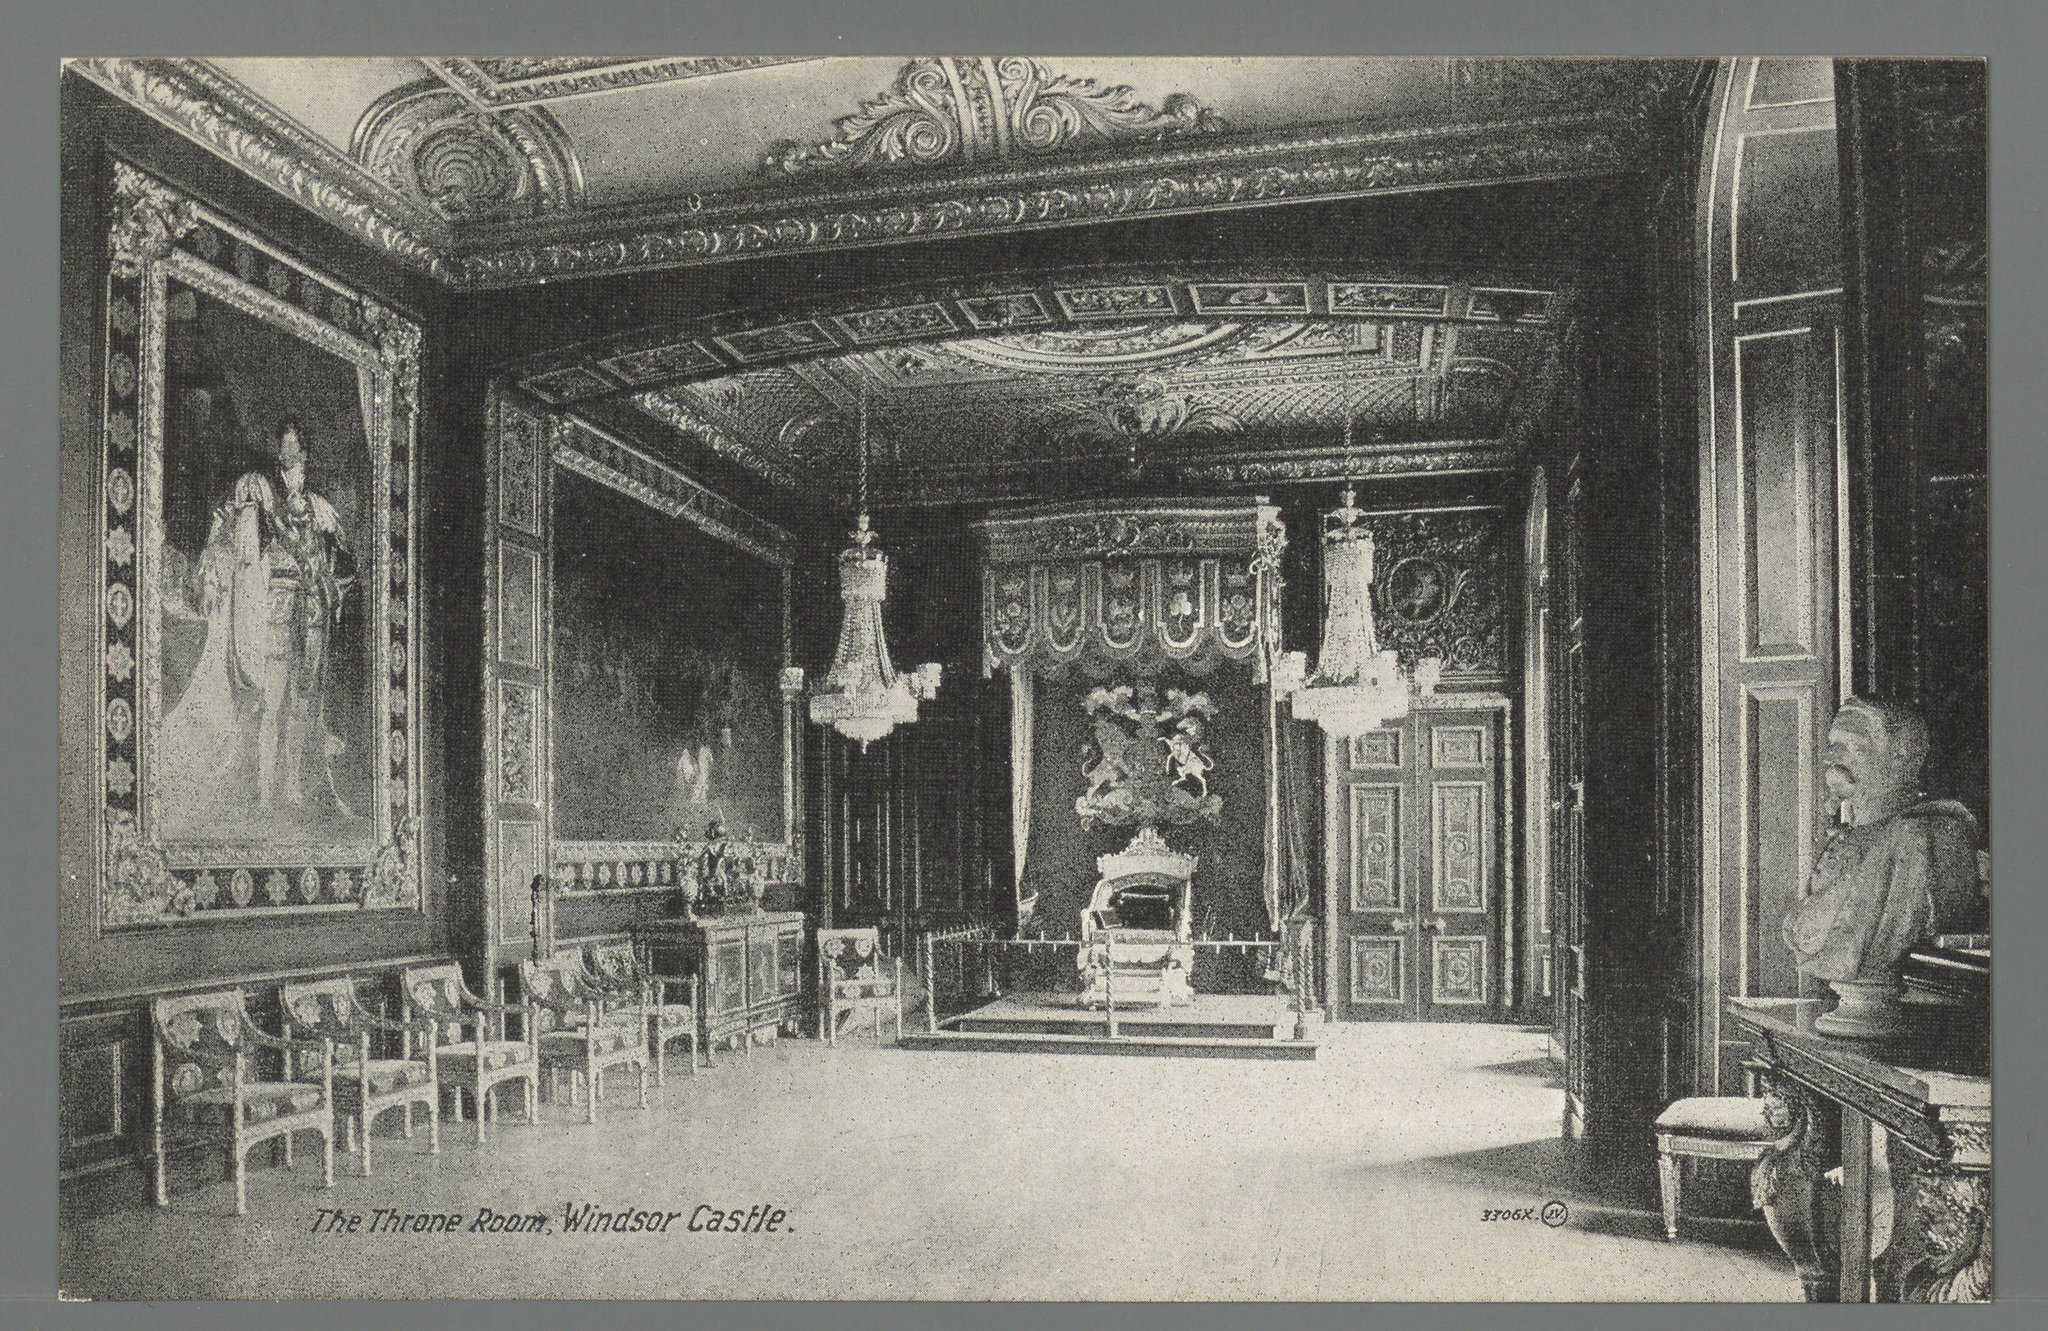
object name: ansichtkaart, prentbriefkaart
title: The Throne Room, Windsor Castle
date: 1902-1930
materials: cardboard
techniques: autotype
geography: great britain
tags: castle, interior of the house